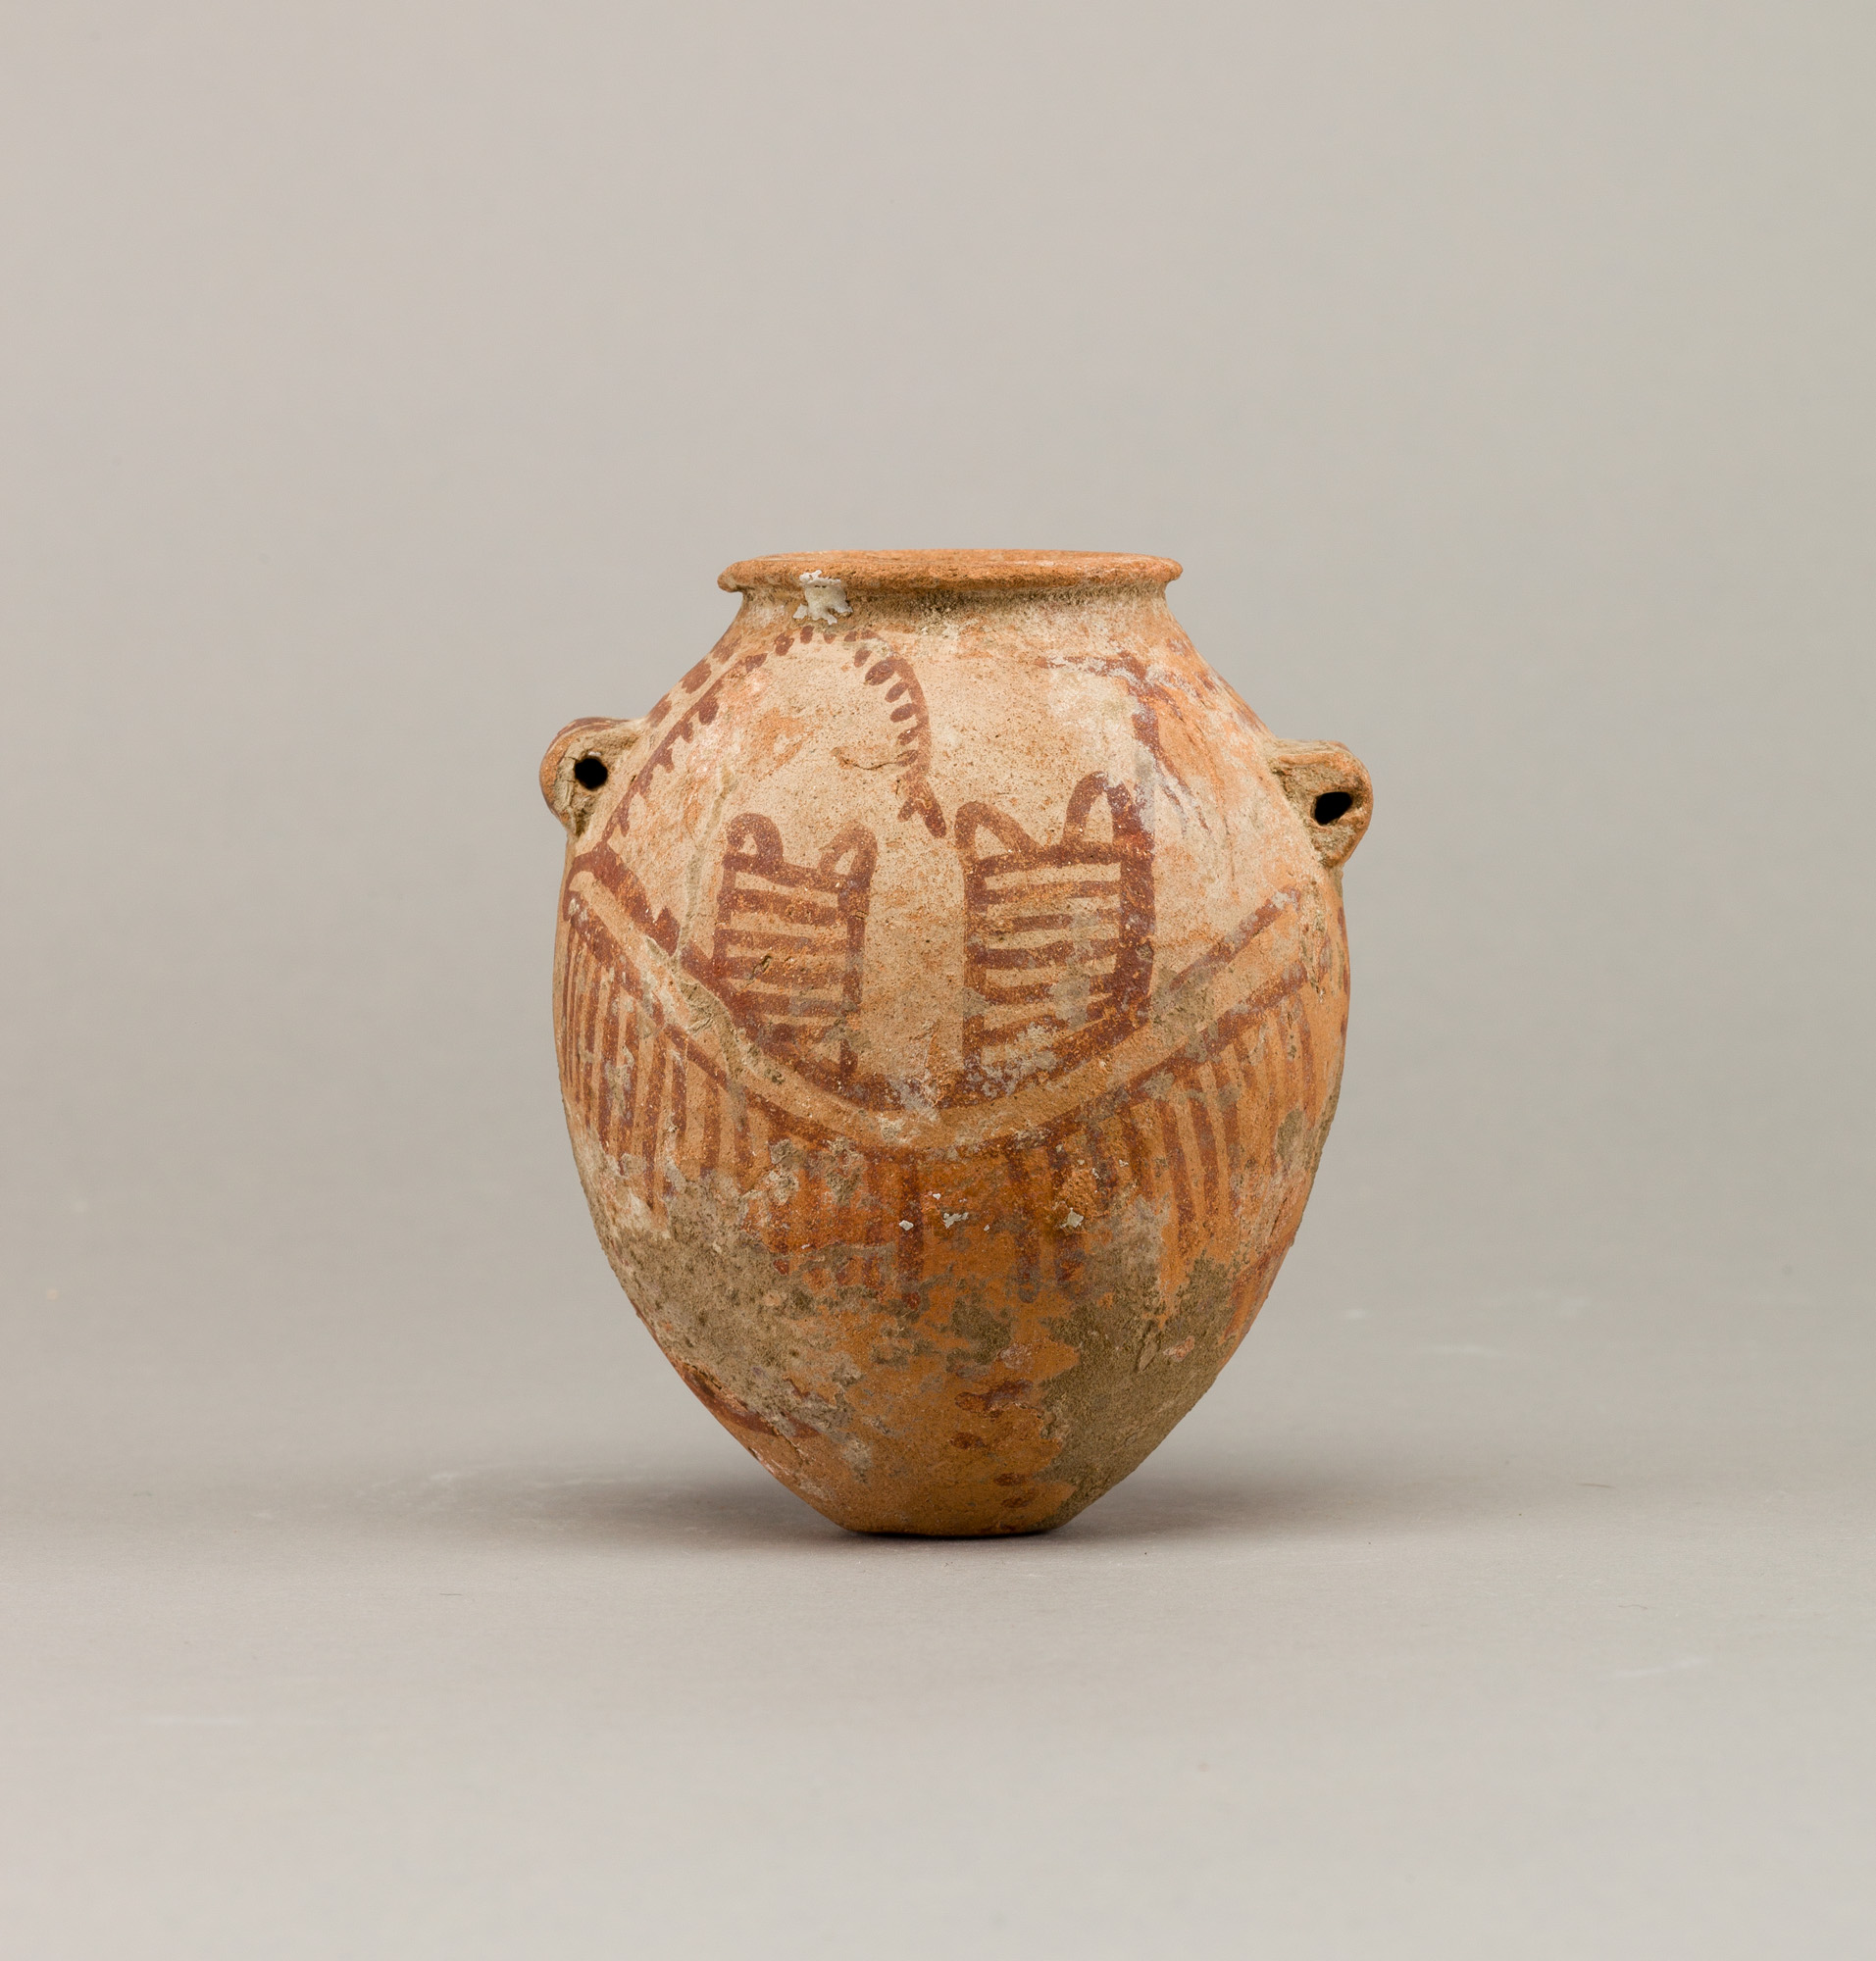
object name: jar, decorated ware, boat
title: Decorated ware jar depicting two boats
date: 3850-2960 BCE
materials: paint, pottery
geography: egypt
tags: boats